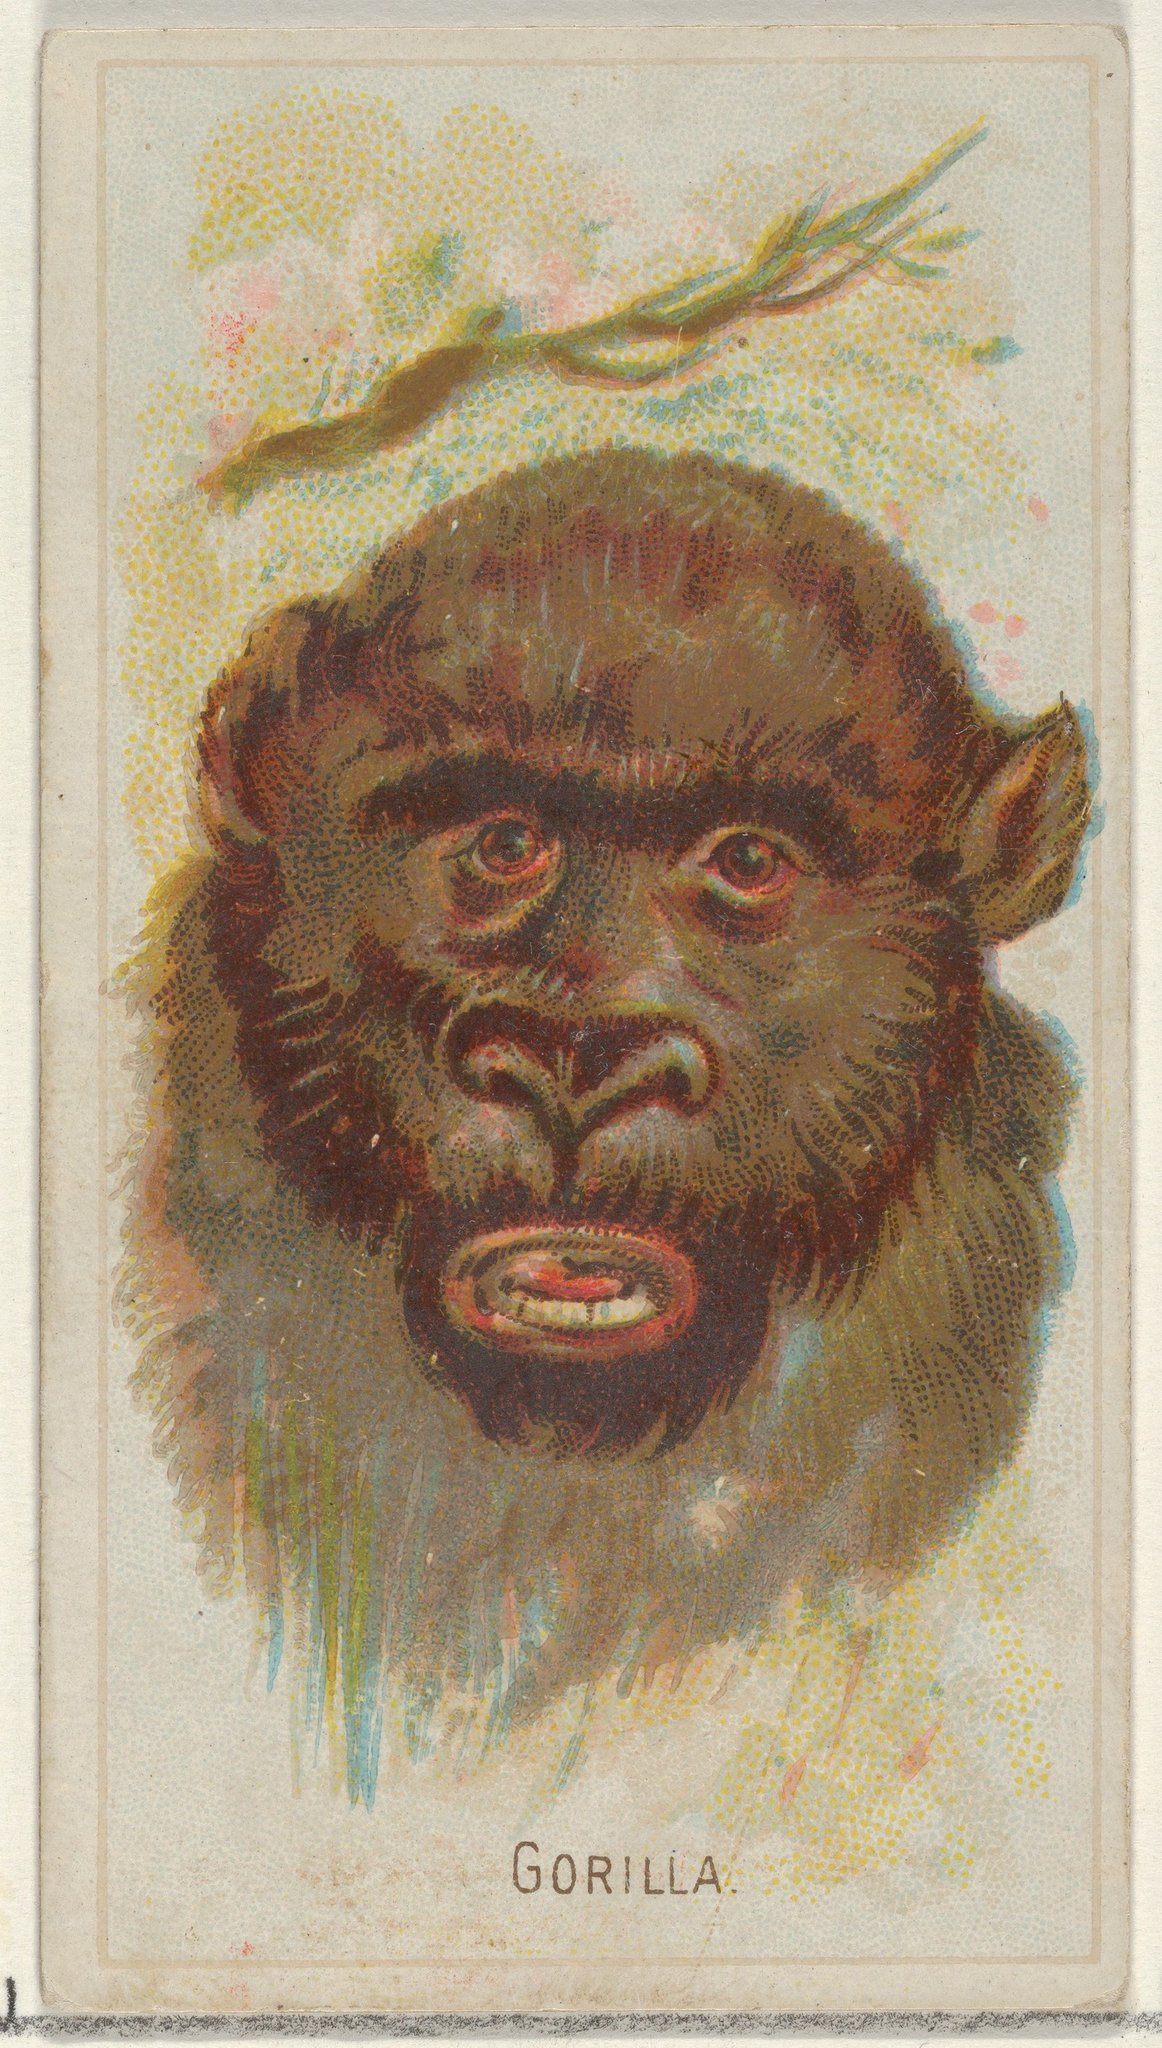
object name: print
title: Gorilla, from the Wild Animals of the World series (N25) for Allen & Ginter Cigarettes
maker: allen & ginter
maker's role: publisher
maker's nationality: american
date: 1888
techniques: color lithograph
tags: animals